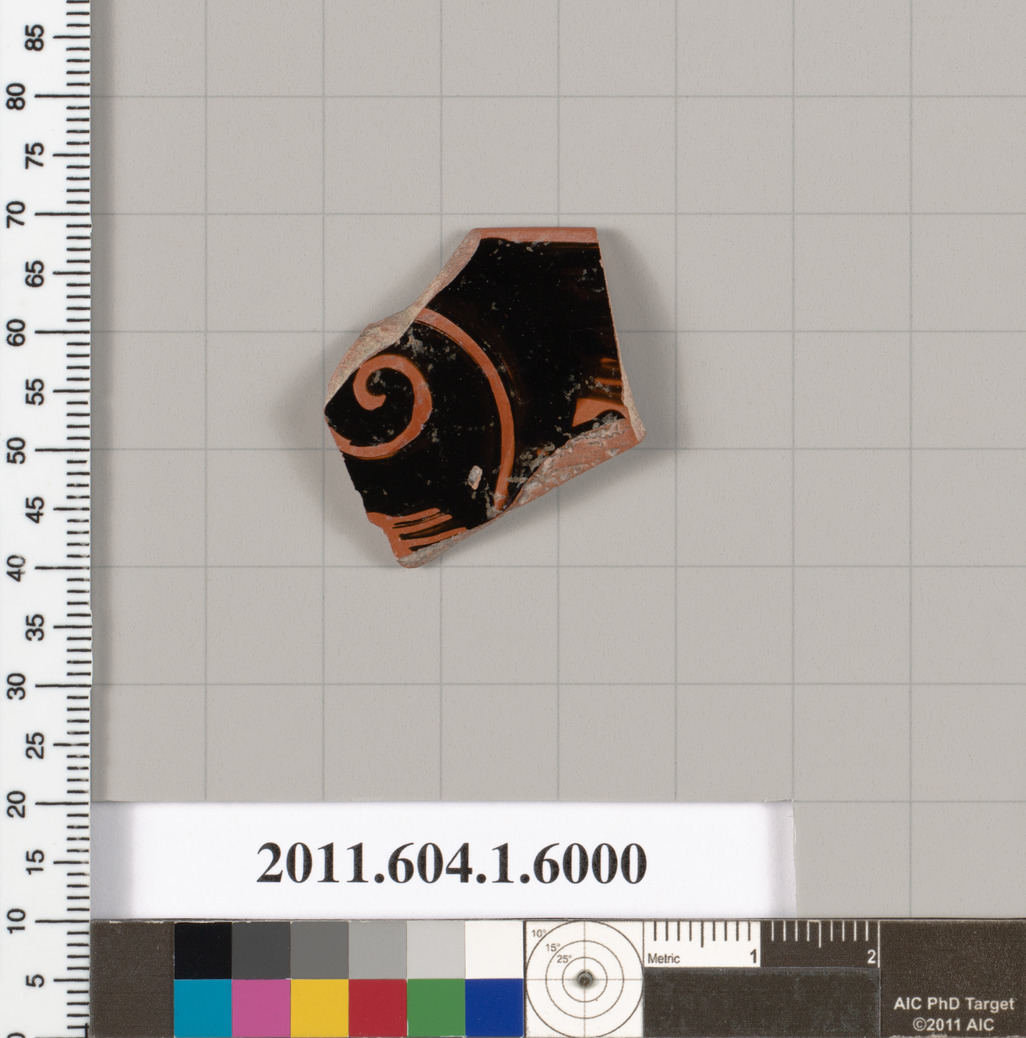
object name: kylix fragment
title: Terracotta rim fragment of a kylix (drinking cup)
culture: greek, attic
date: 510-500 BCE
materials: terracotta